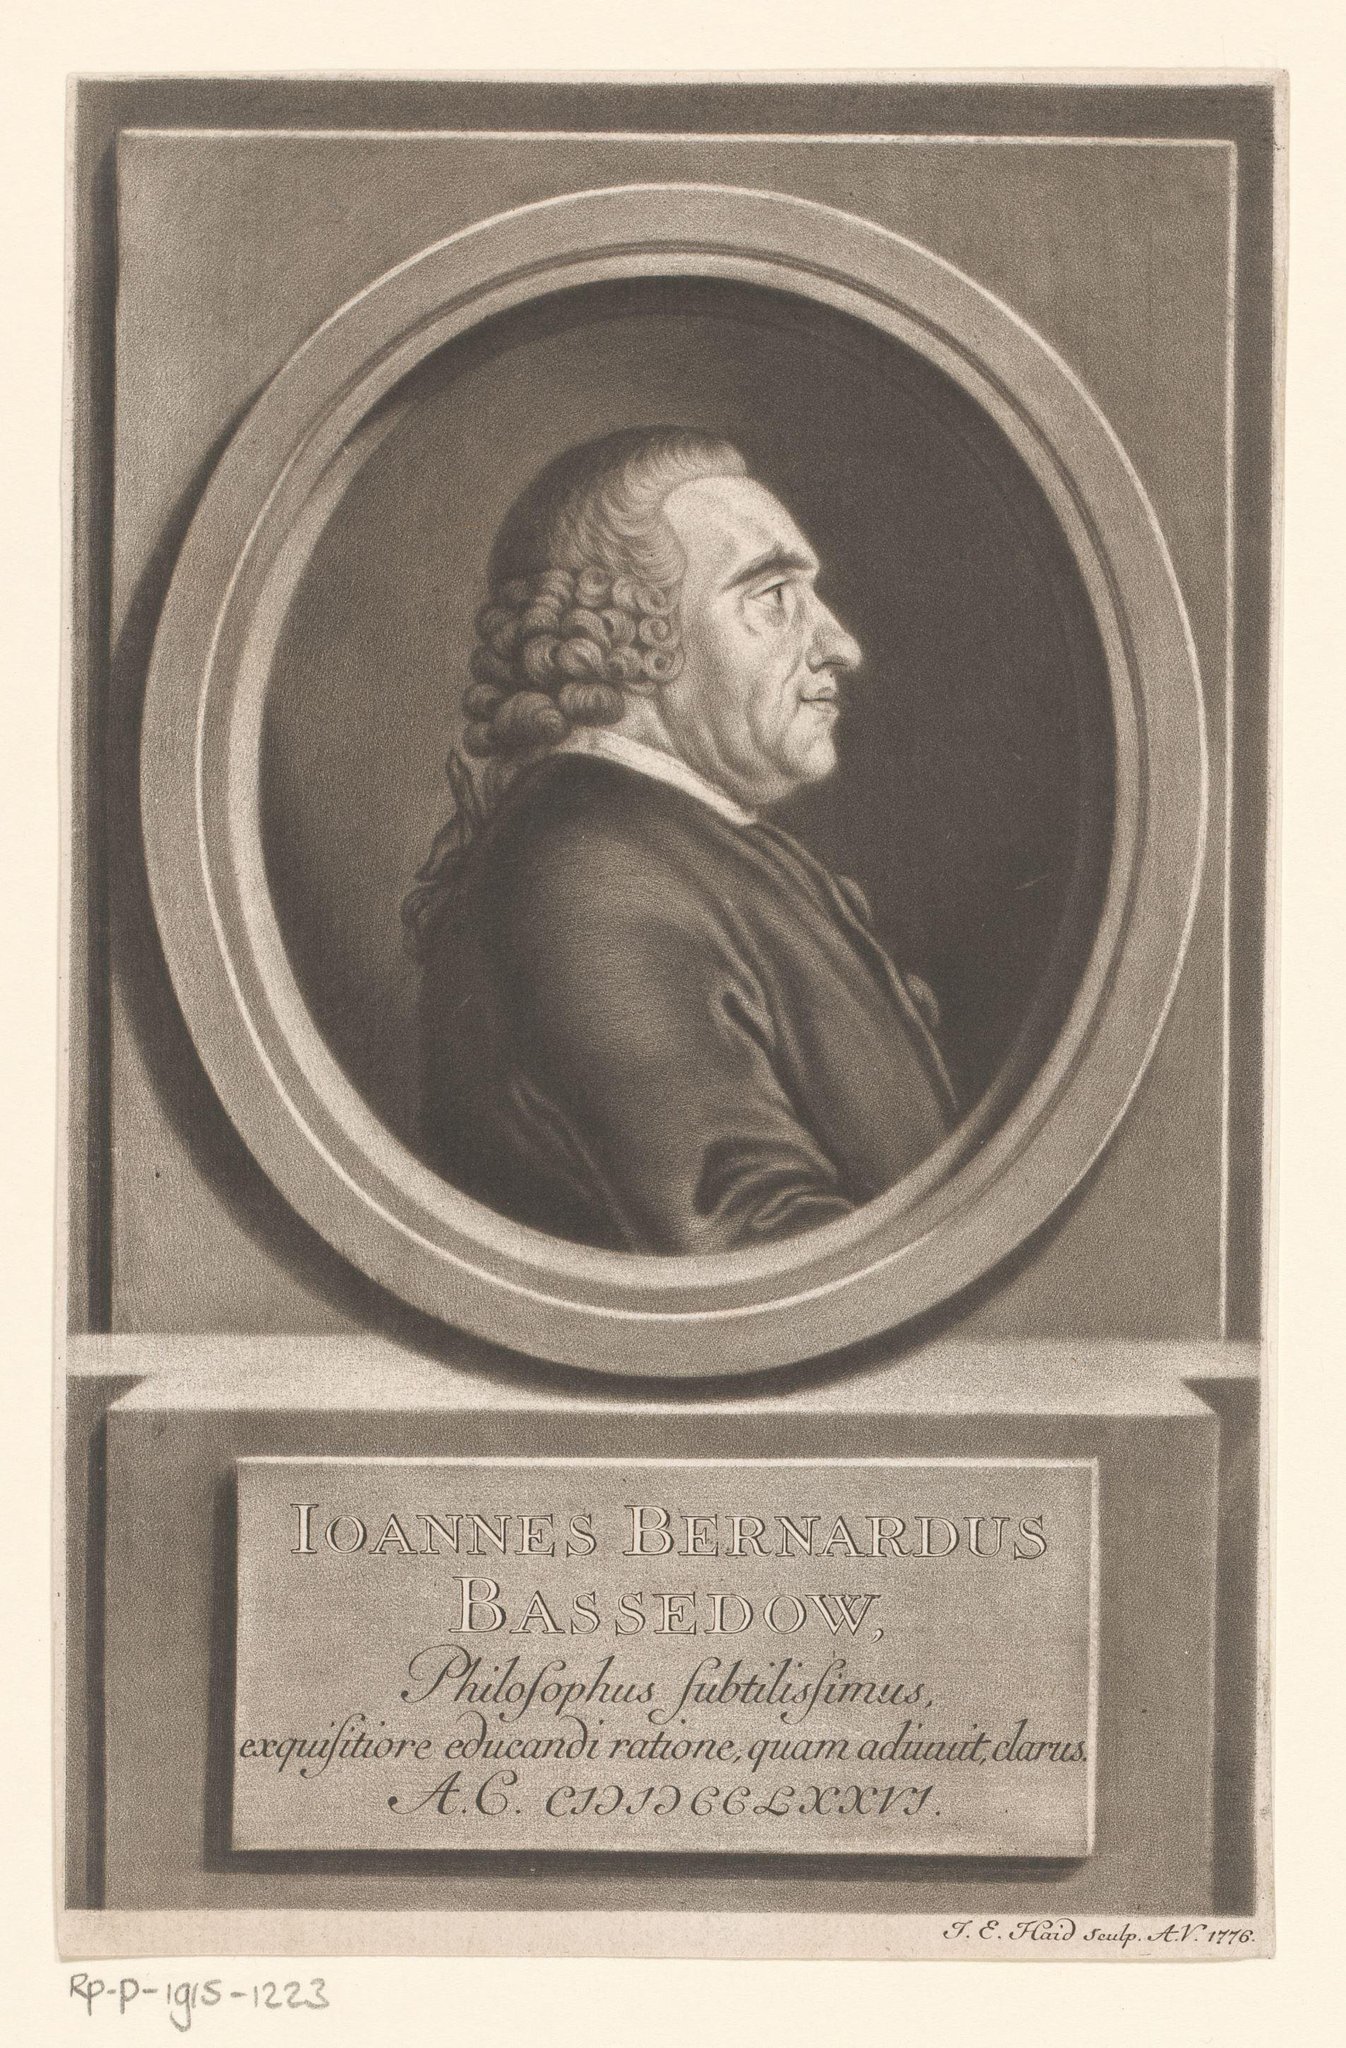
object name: print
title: Portret van Johann Bernhard Basedow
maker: johann elias haid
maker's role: print maker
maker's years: 1739-1809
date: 1776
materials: paper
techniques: mezzotint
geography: augsburg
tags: johann bernhard basedow, scholar, philosopher, historical persons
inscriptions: collector's mark: Lugt 2228